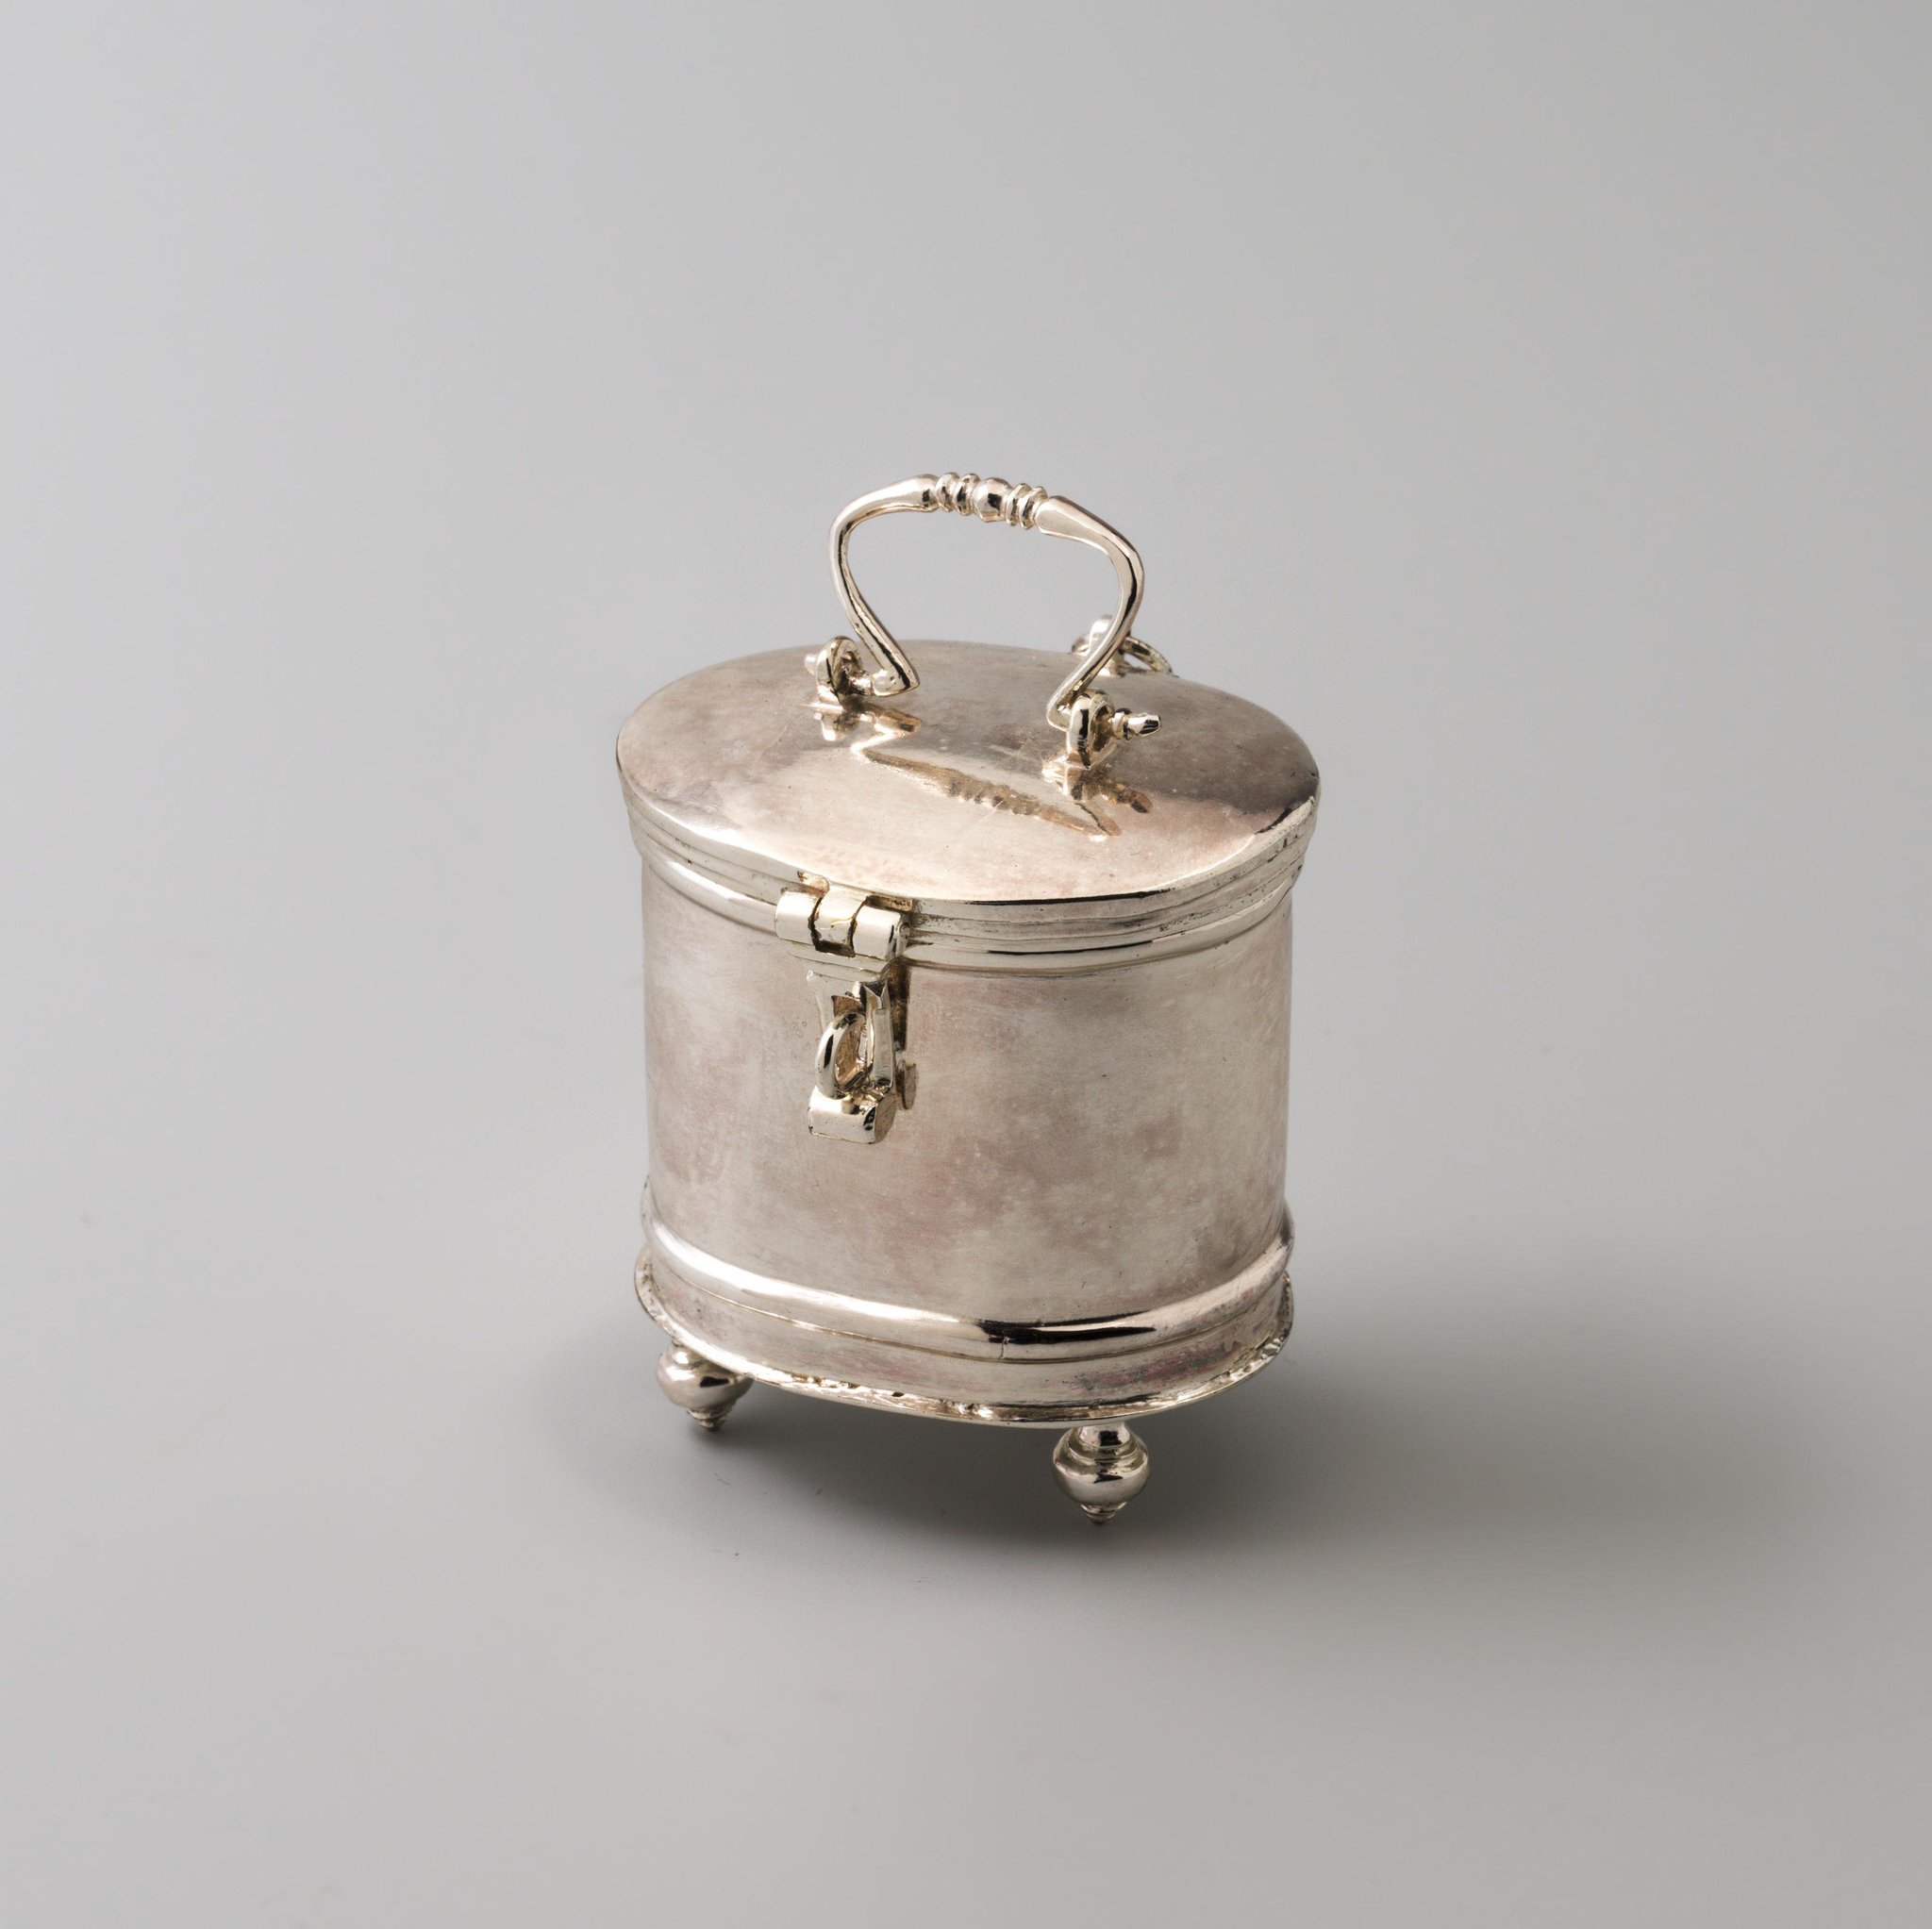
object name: tin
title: Trommel of blik van zilver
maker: michiel maenbeeck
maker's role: silversmith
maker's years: 1634-1682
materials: silver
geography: haarlem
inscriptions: maker's mark: ‘wassende maan (Citroen 1975, nr. 1166)’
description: Trommel of blik van zilver, glad met ribbelversiering, met scharnierend deksel, met sluiting voor hangslot, bovenop een scharnierend handvat, op drie bolpootjes, met ring om de bus op te hangen.